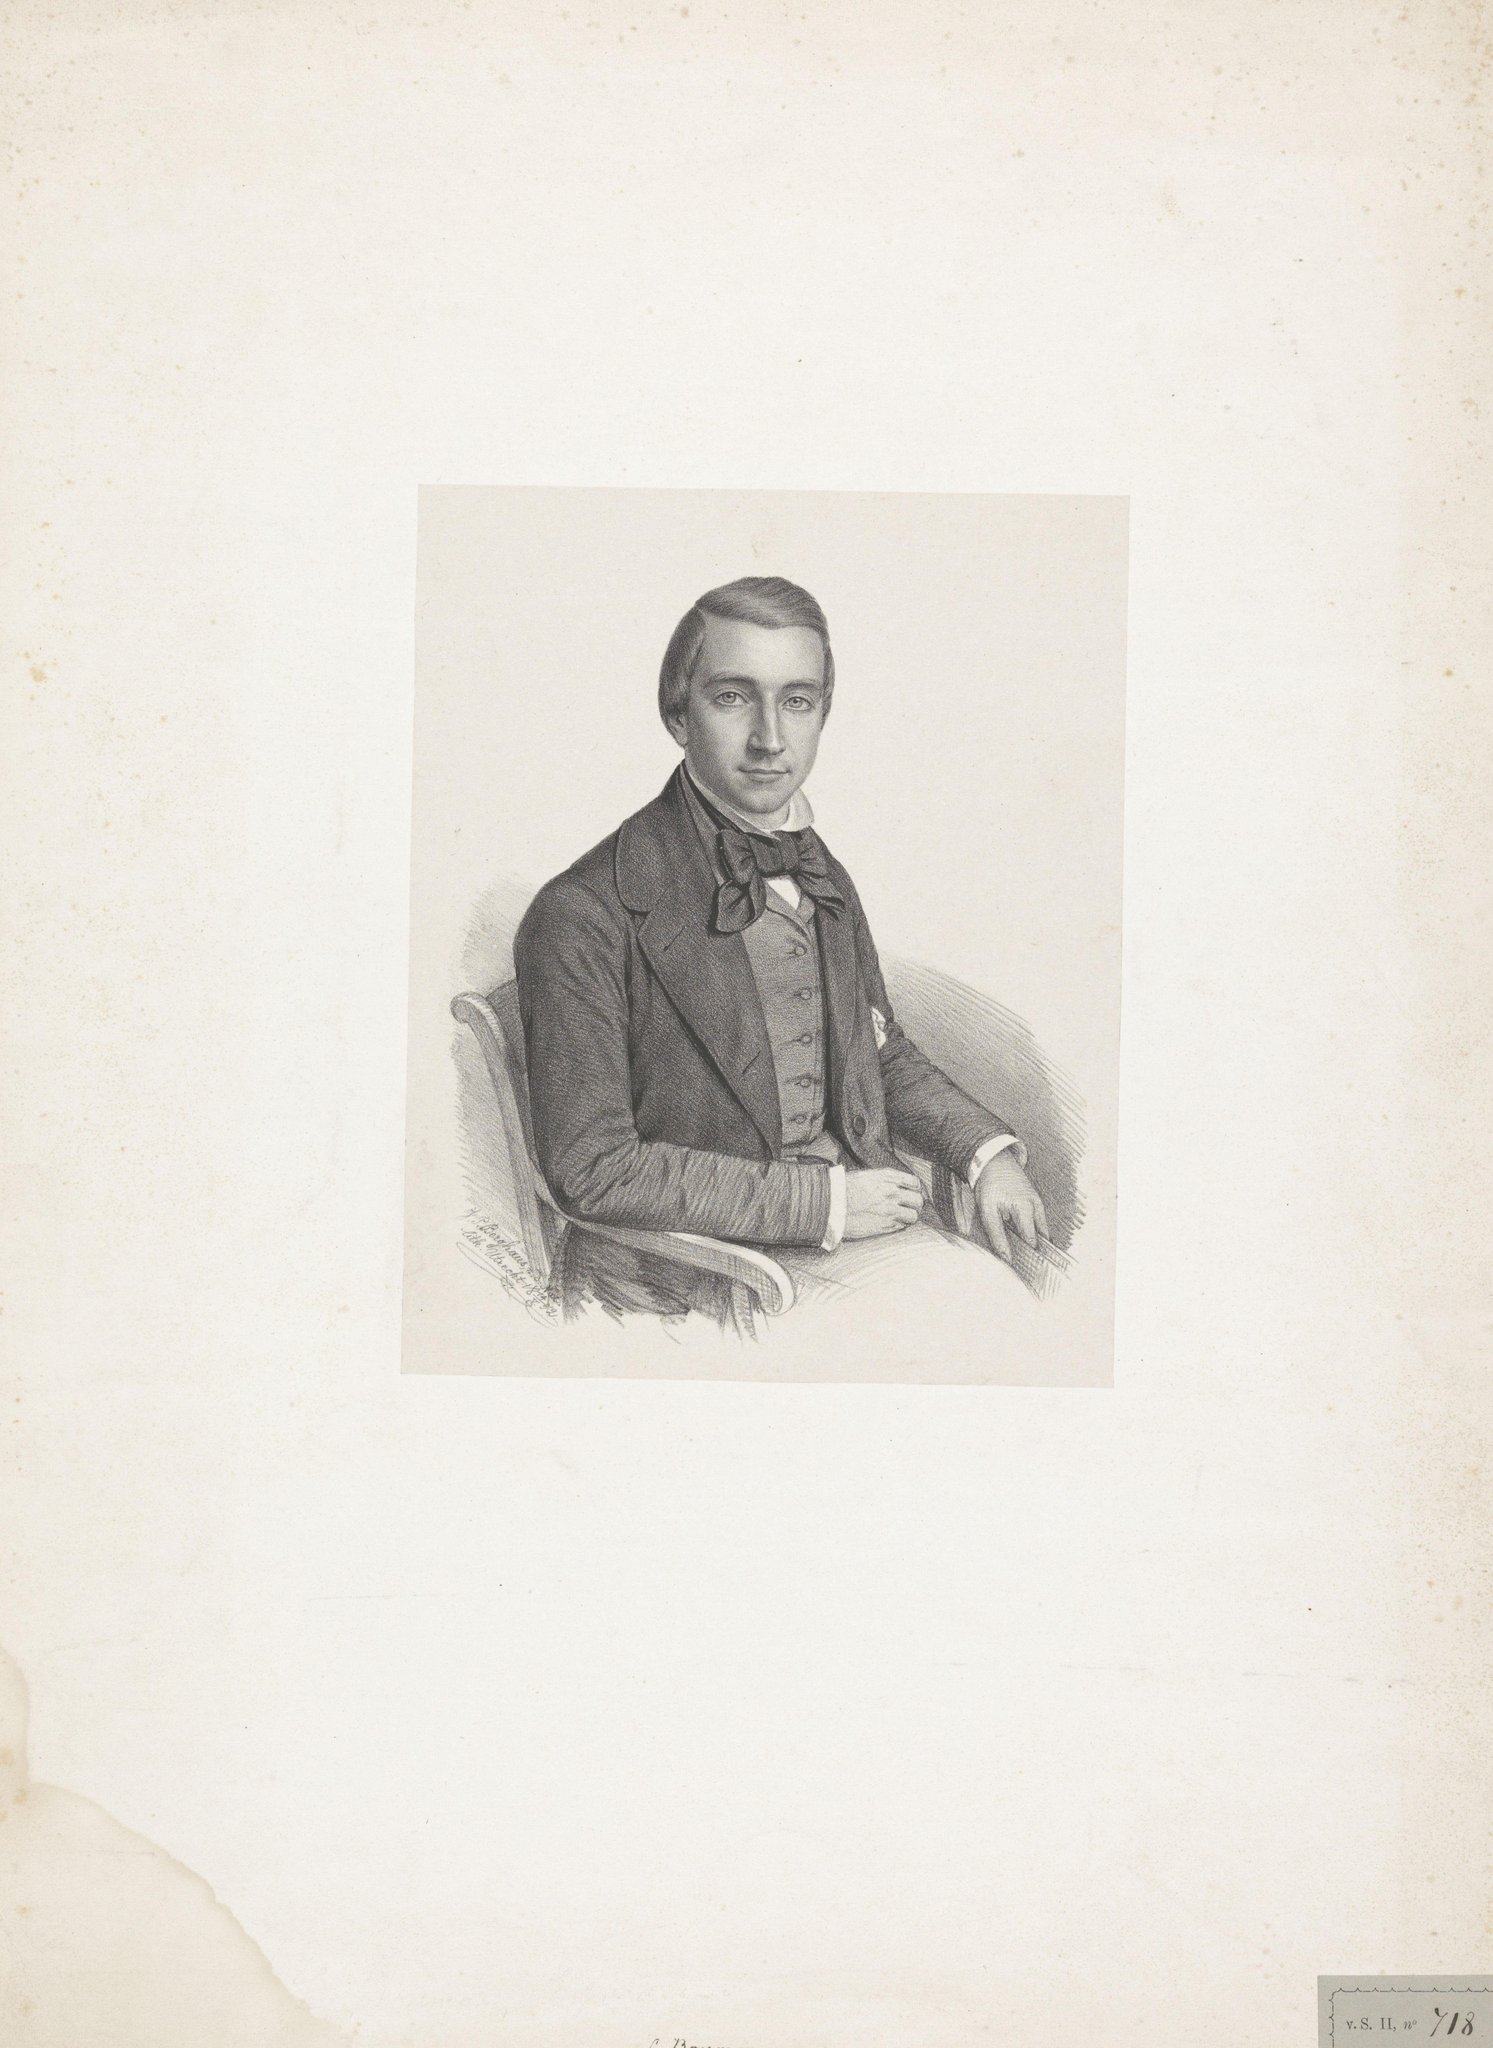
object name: print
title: Portret van L. Bouman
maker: johann peter berghaus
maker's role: print maker, printer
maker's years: 1810-1870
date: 1852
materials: paper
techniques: lithograph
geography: utrecht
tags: historical persons, book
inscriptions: inscription: ‘L. Bouman.’, collector's mark: Lugt 2228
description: De geportretteerde zit op een stoel. Zijn rechterarm rust in zijn schoot, zijn linkerarm rust op de leuning van de stoel. In zijn linkerhand heeft hij een boek met een vinger tussen de bladzijden.